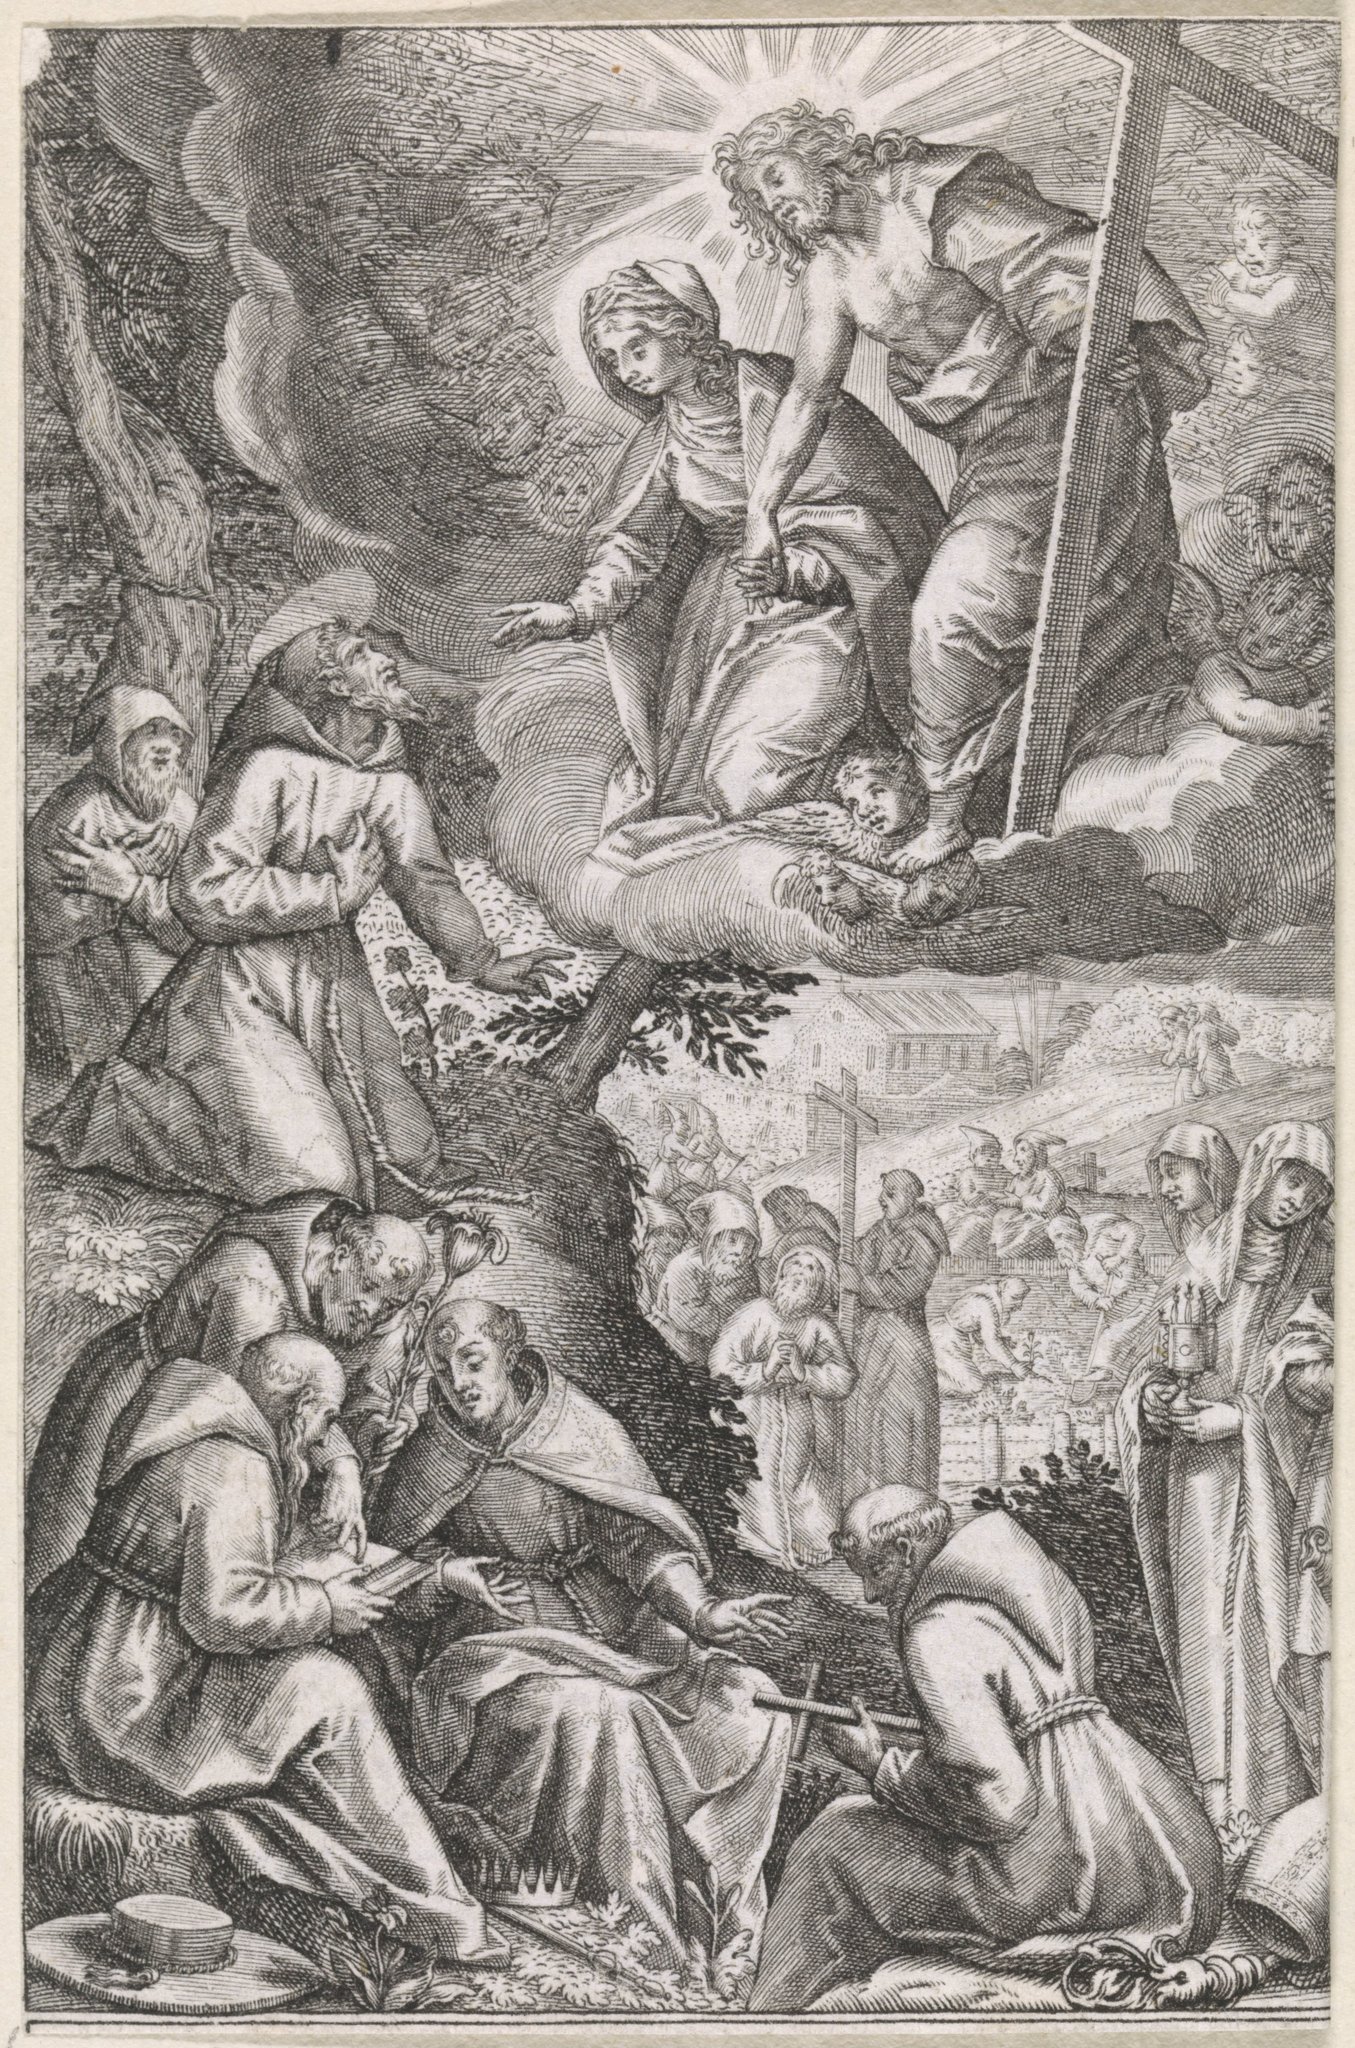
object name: print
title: Christus en de maagd maria verschijnen aan de Heilige Franciscus en zijn orde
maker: raphaël sadeler (ii)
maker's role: print maker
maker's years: 1584-1632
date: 1581-1633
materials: paper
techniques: engraving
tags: monastic orders, monastic life ~ roman catholic church (with name of order), after the miracle of the roses, christ and mary appear to st. francis of assisi in the portiuncula chapel (+ angel(s))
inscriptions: collector's mark: Lugt 2228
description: Op de voorgrond enkele franciscaner monniken. Ze lezen uit een bijbel. Op de grond liggen de symbolen van wereldlijke en geestelijke macht (kroon, mijter en kardinaalshoed). Op een heuvel knielt de H. Franciscus voor de verschijning van Christus en de maagd Maria. Onder de verschijning de activiteiten van de orde der Franciscanen.